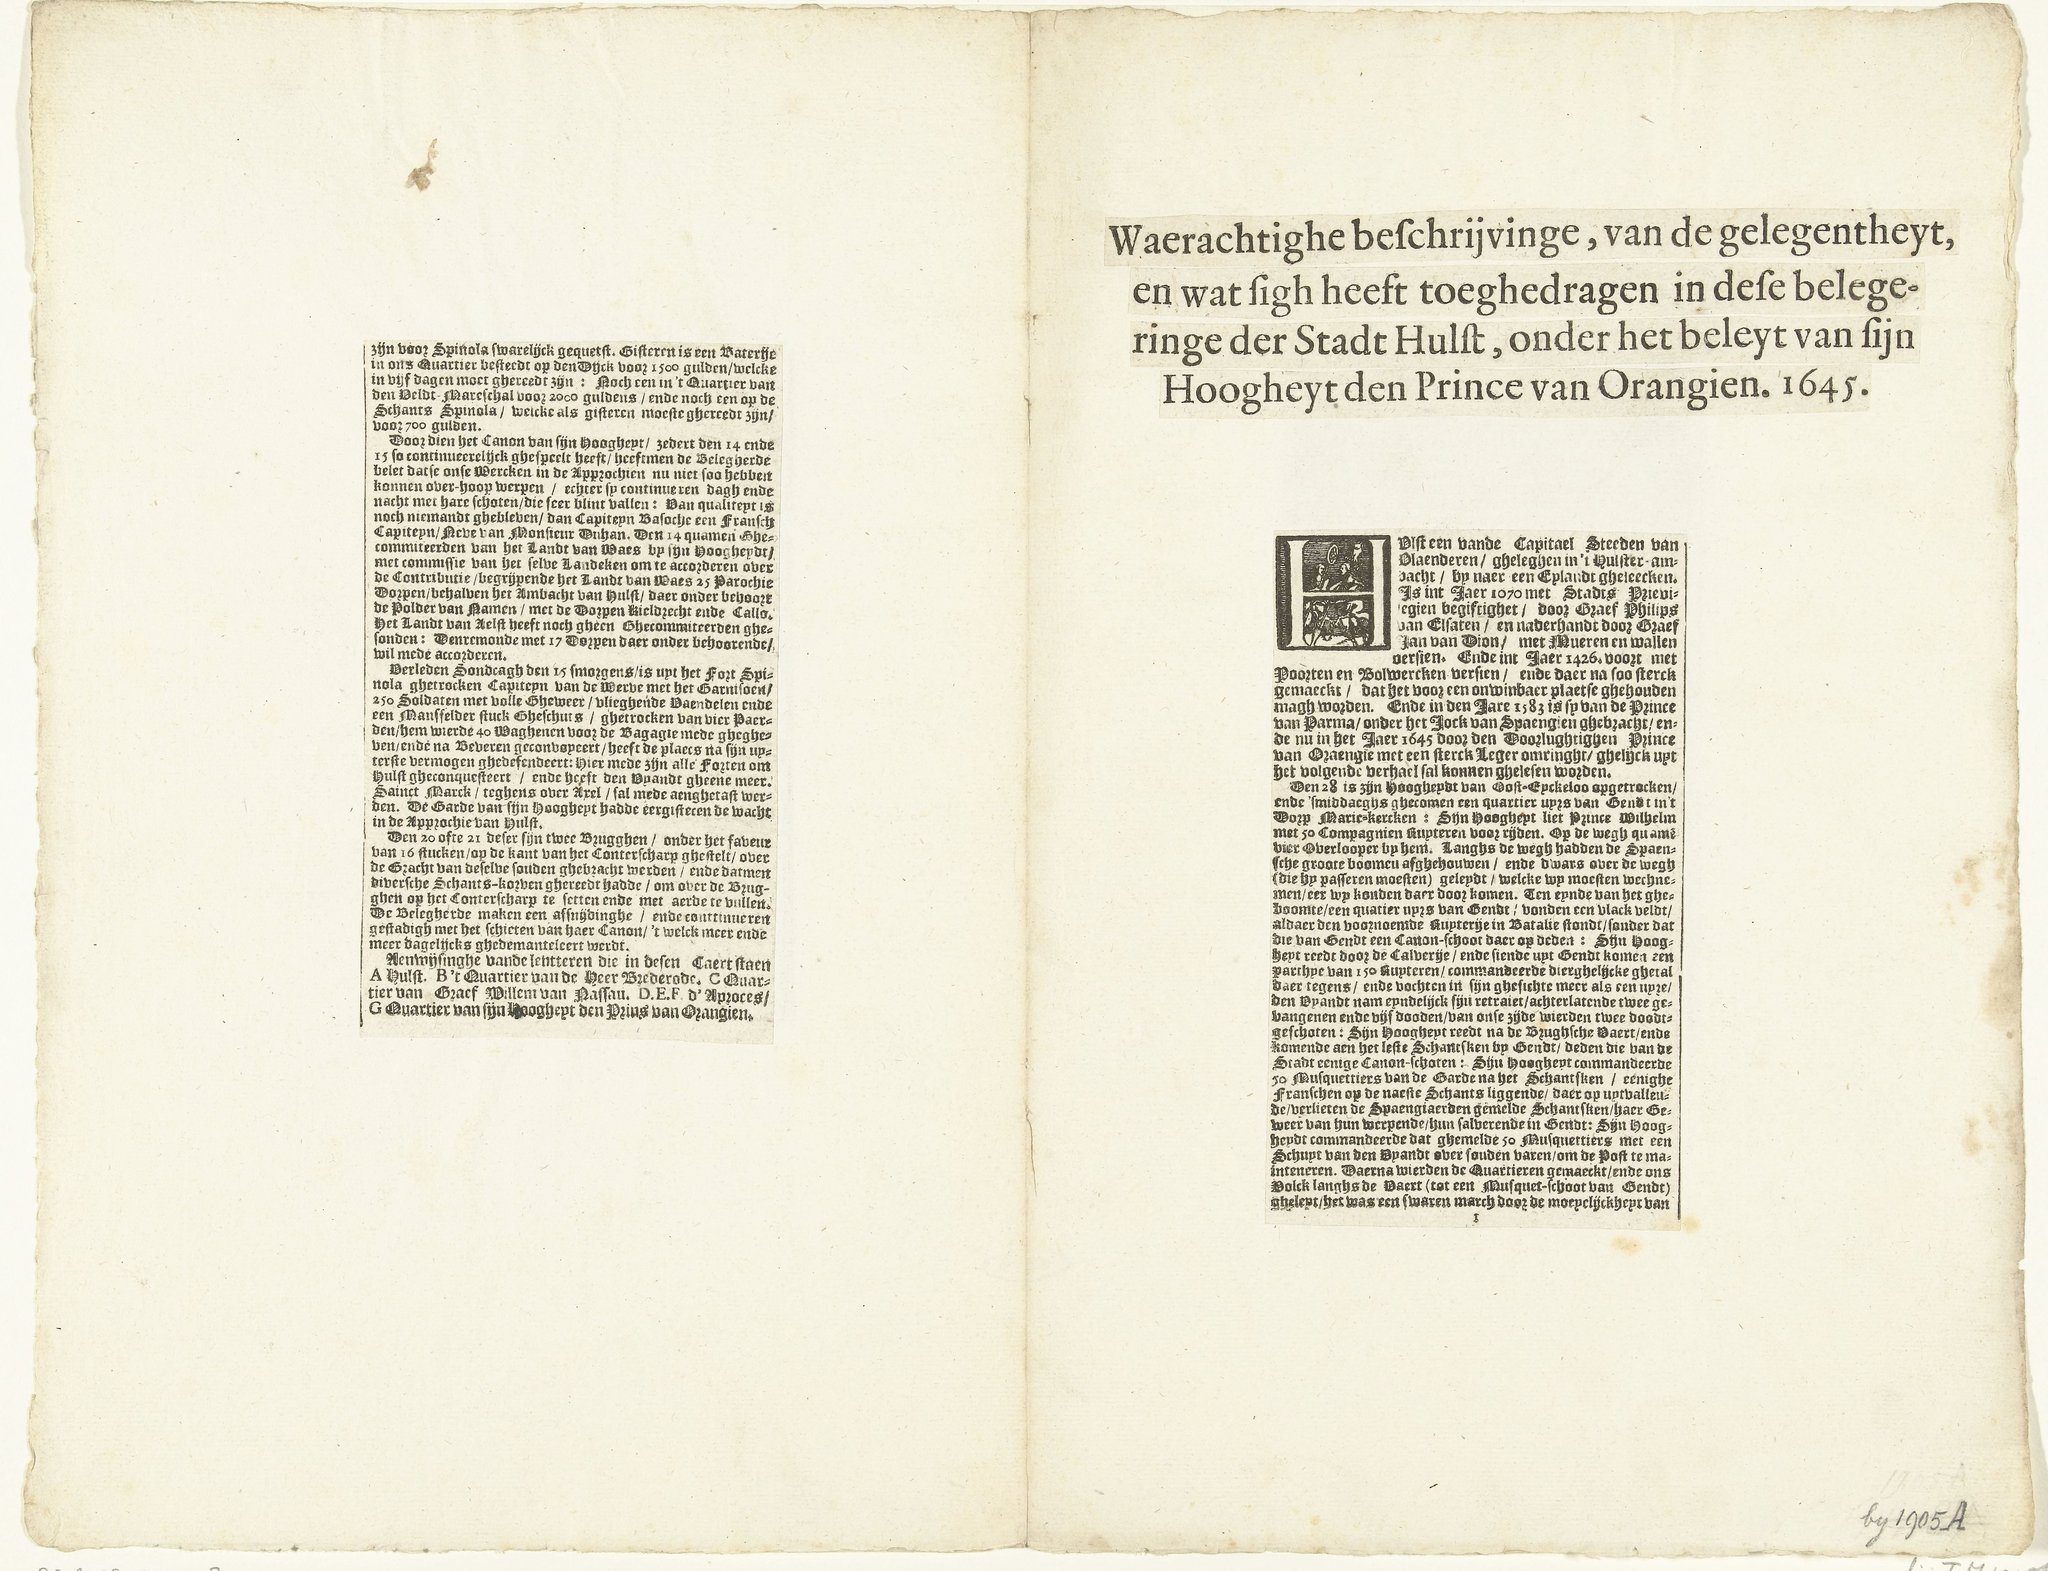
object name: text sheet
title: Waerachtighe beschrijvinge, van de gelegentheyt, en wat sigh heeft toeghedragen in dese belegeringe der Stadt Hulst, onder het beleyt van sijn Hoogheyt den Prince van Orangien. 1645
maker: Anonymous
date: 1645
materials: paper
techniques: letterpress printing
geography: northern netherlands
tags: delft, the hague, frederick henry (prince of orange)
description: Teksten bij de prent van het beleg en verovering van Hulst door het Staatse leger onder Frederik Hendrik van 28 september tot 5 november 1645. Vier lossen kolommen met een beschrijving van de gebeurtenissen en de legenda A-G, uitgeknipt en op de voor- en achterzijde van een blad papier geplakt. Bovenaan de titel in vier uitgeknipte en opgeplakte stroken.